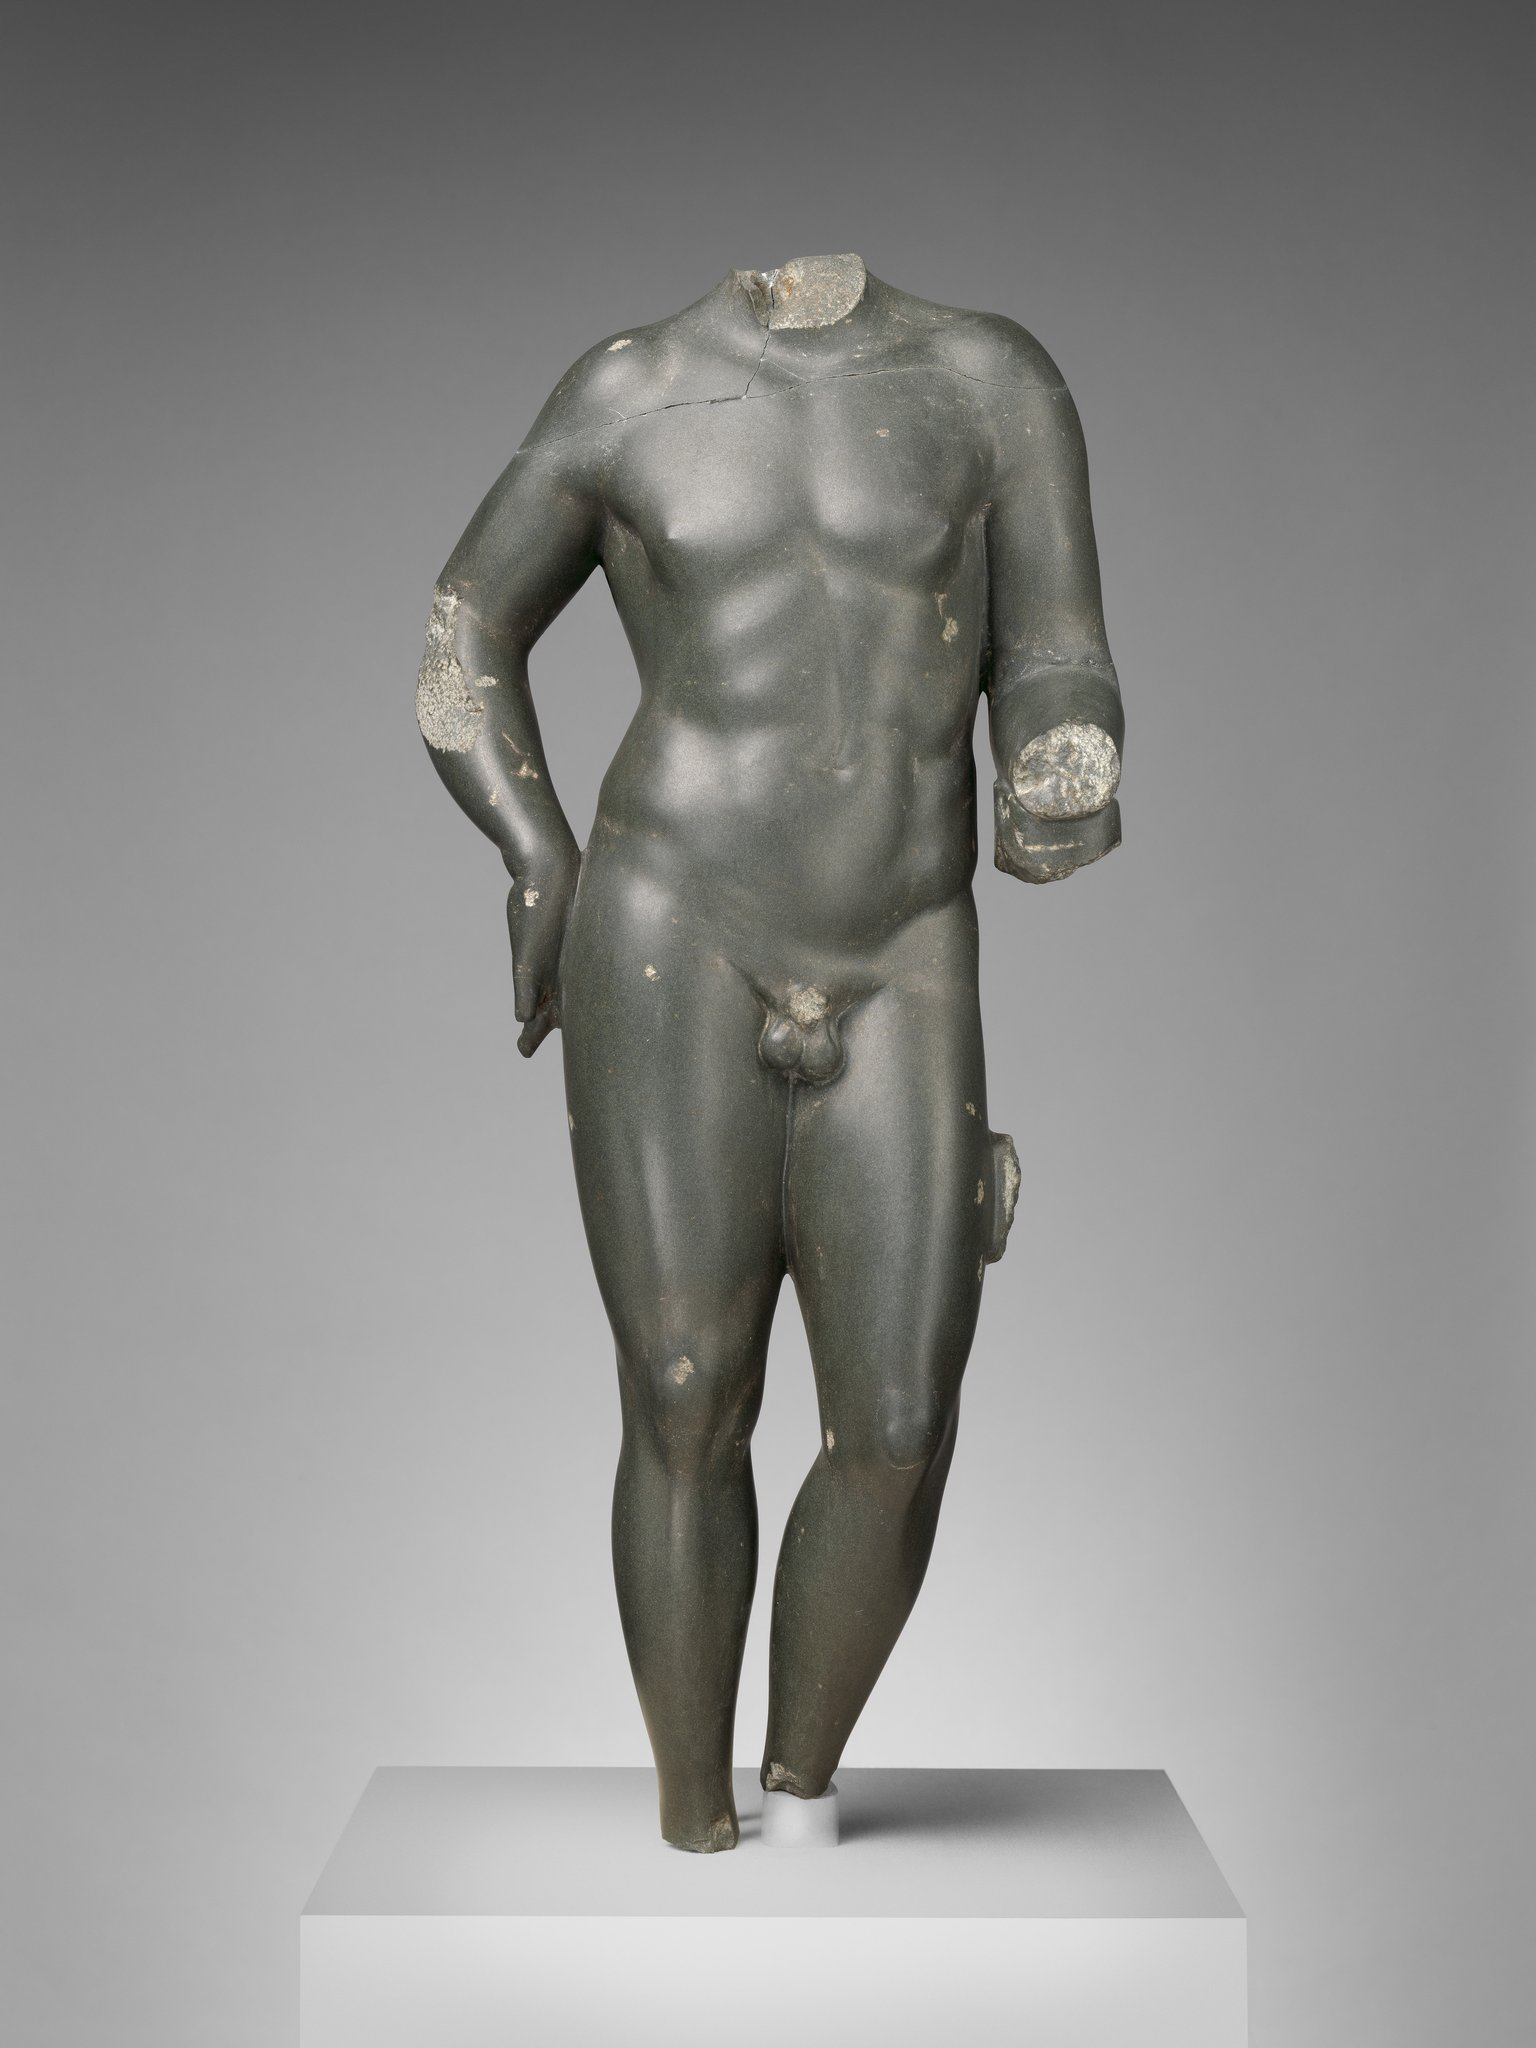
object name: statuette of a youth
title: Statue of a boy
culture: roman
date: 1-100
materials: stone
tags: male nudes